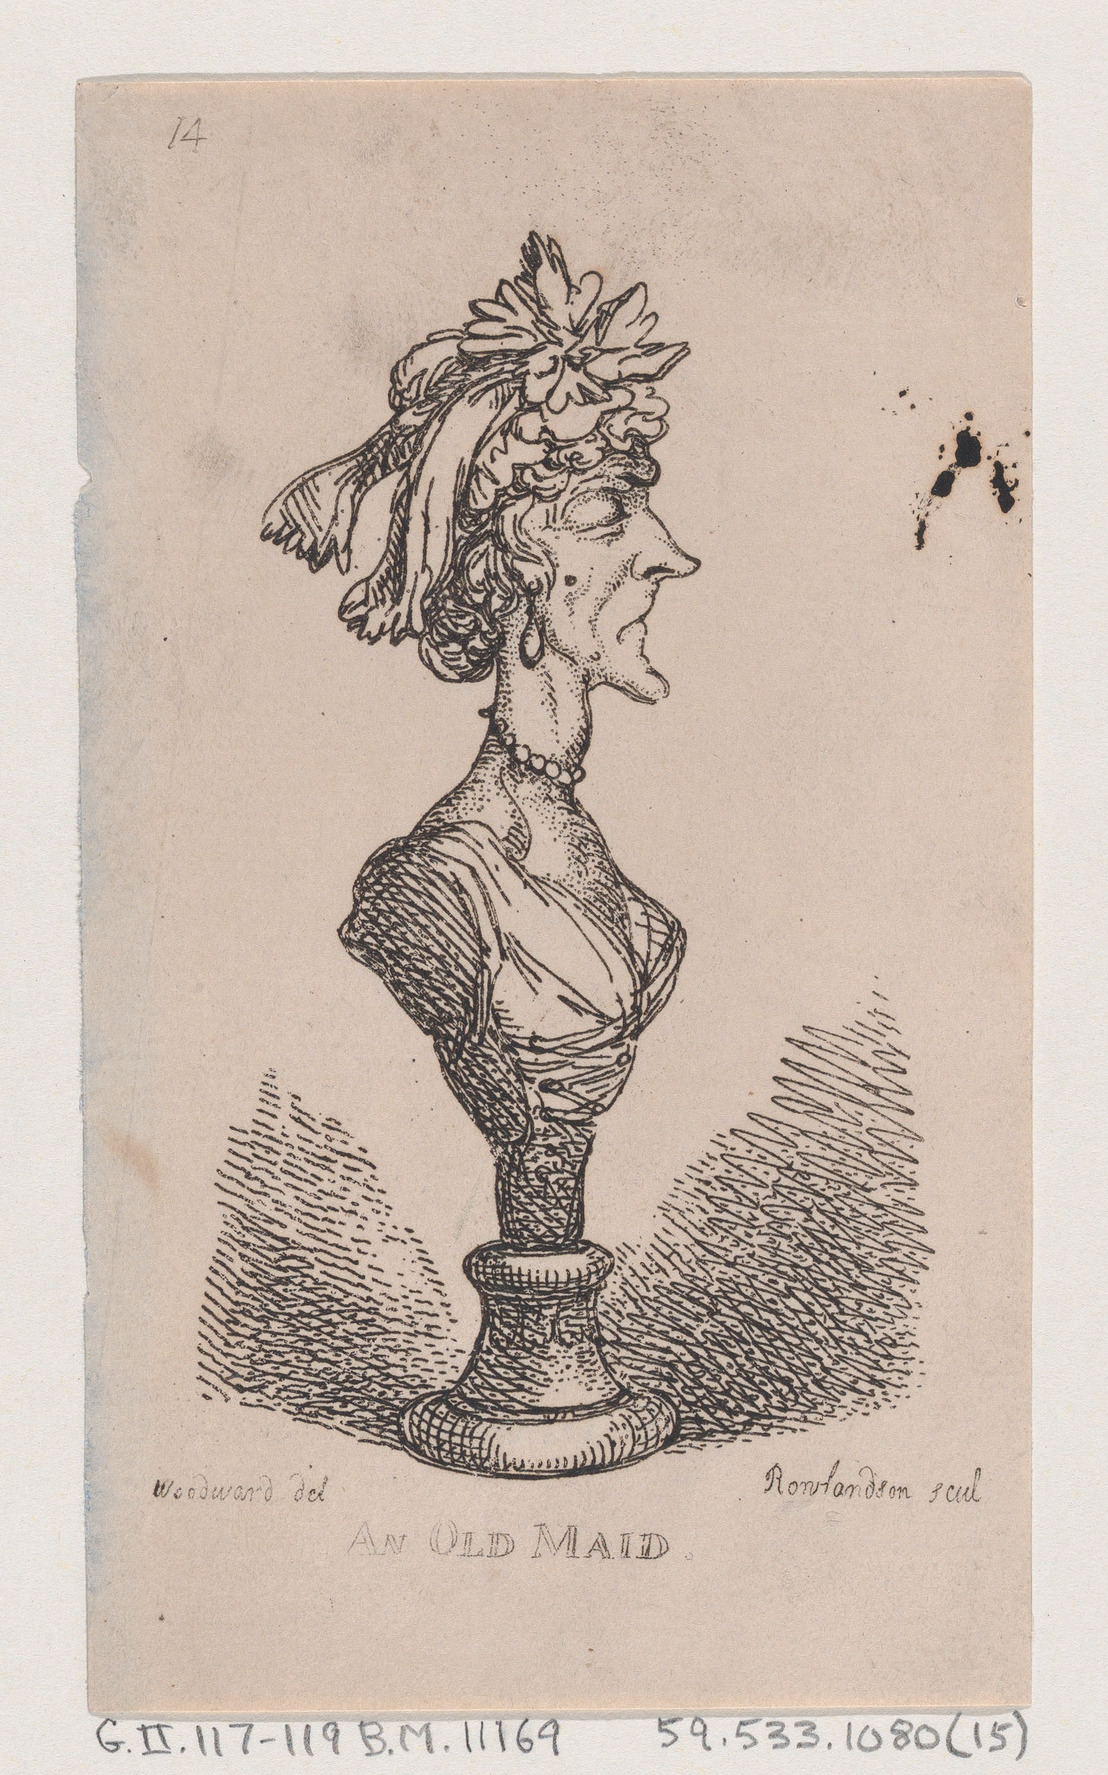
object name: print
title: An Old Maid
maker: thomas rowlandson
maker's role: artist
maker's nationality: british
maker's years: 1757-1827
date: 1808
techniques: etching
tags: satire,women